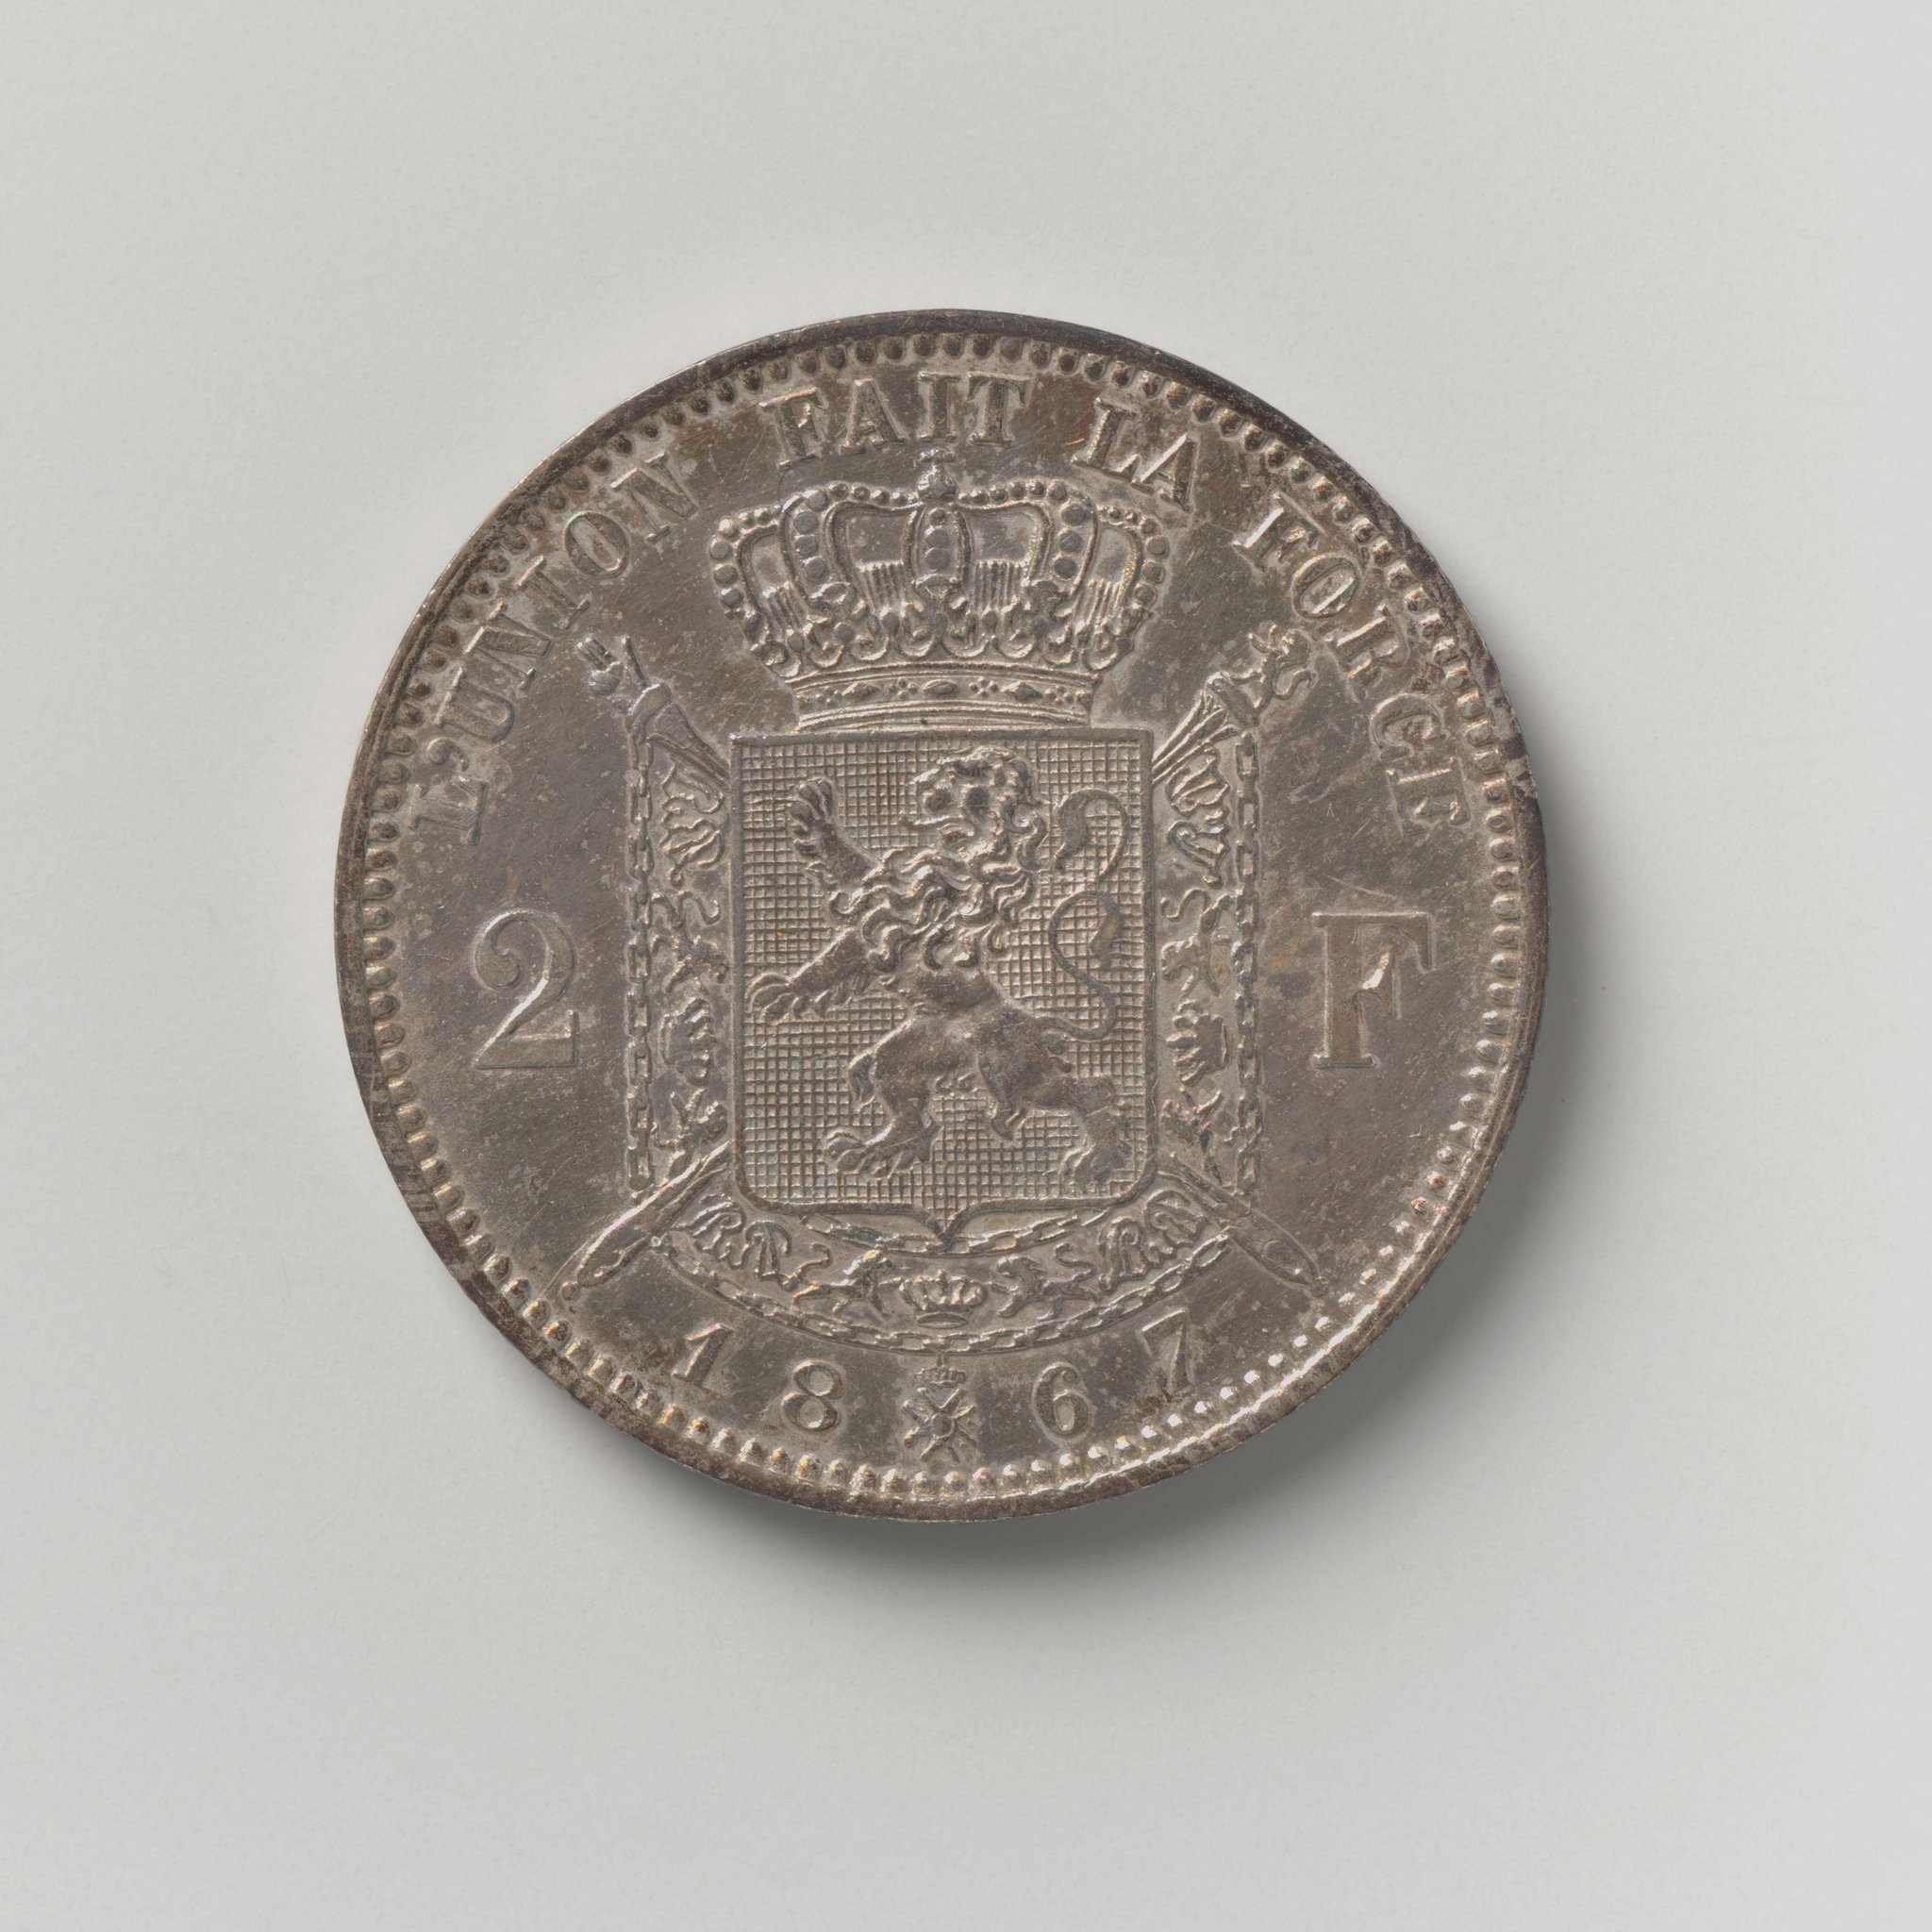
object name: coin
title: België, Leopold II, 2 francs, 1867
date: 1867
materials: silver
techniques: striking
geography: brussels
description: Zilveren munt. Voorzijde: borstbeeld van de koning naar links. Keerzijde: tussen waarde-aanduiding op twee gekruiste staven, waarop keten van de leopoldsorde is gehangen,geplaatst gekroond wapenschild. Jaartal onderaan. Kartelrand.